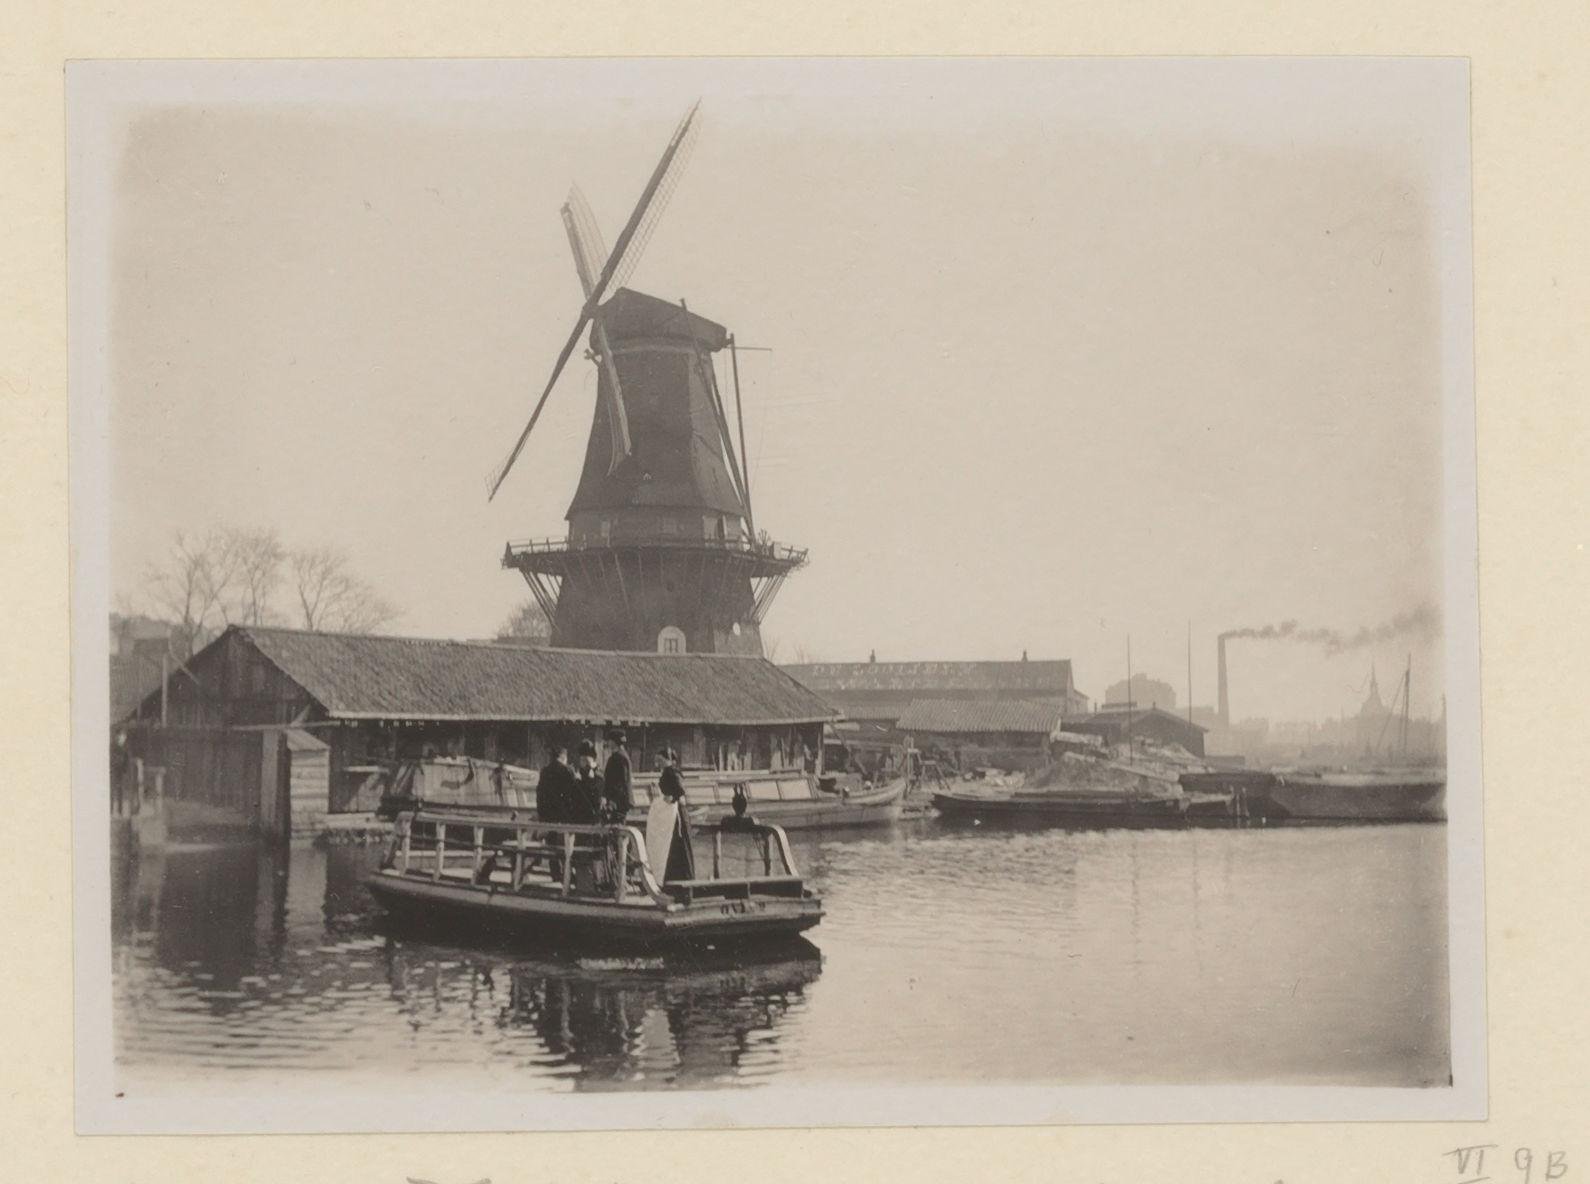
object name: photograph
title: Gezicht op molen De Victor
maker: Anonymous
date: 1875-1925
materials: paper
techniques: gelatin silver print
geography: amsterdam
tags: city-view in general; 'veduta', canal, windmill in landscape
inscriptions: collector's mark: ‘6’ Lugt 1641b, inscription: ‘Molen "de Victor" gezien v.d. Nassaukade / van Noord naar Zuid’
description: Onderwerpsrubriek binnen de Atlas Amsterdam: Buitensingel of wel: Gezichten langs en op de Stadsvest van Haarlemmerpoort tot Raampoort.